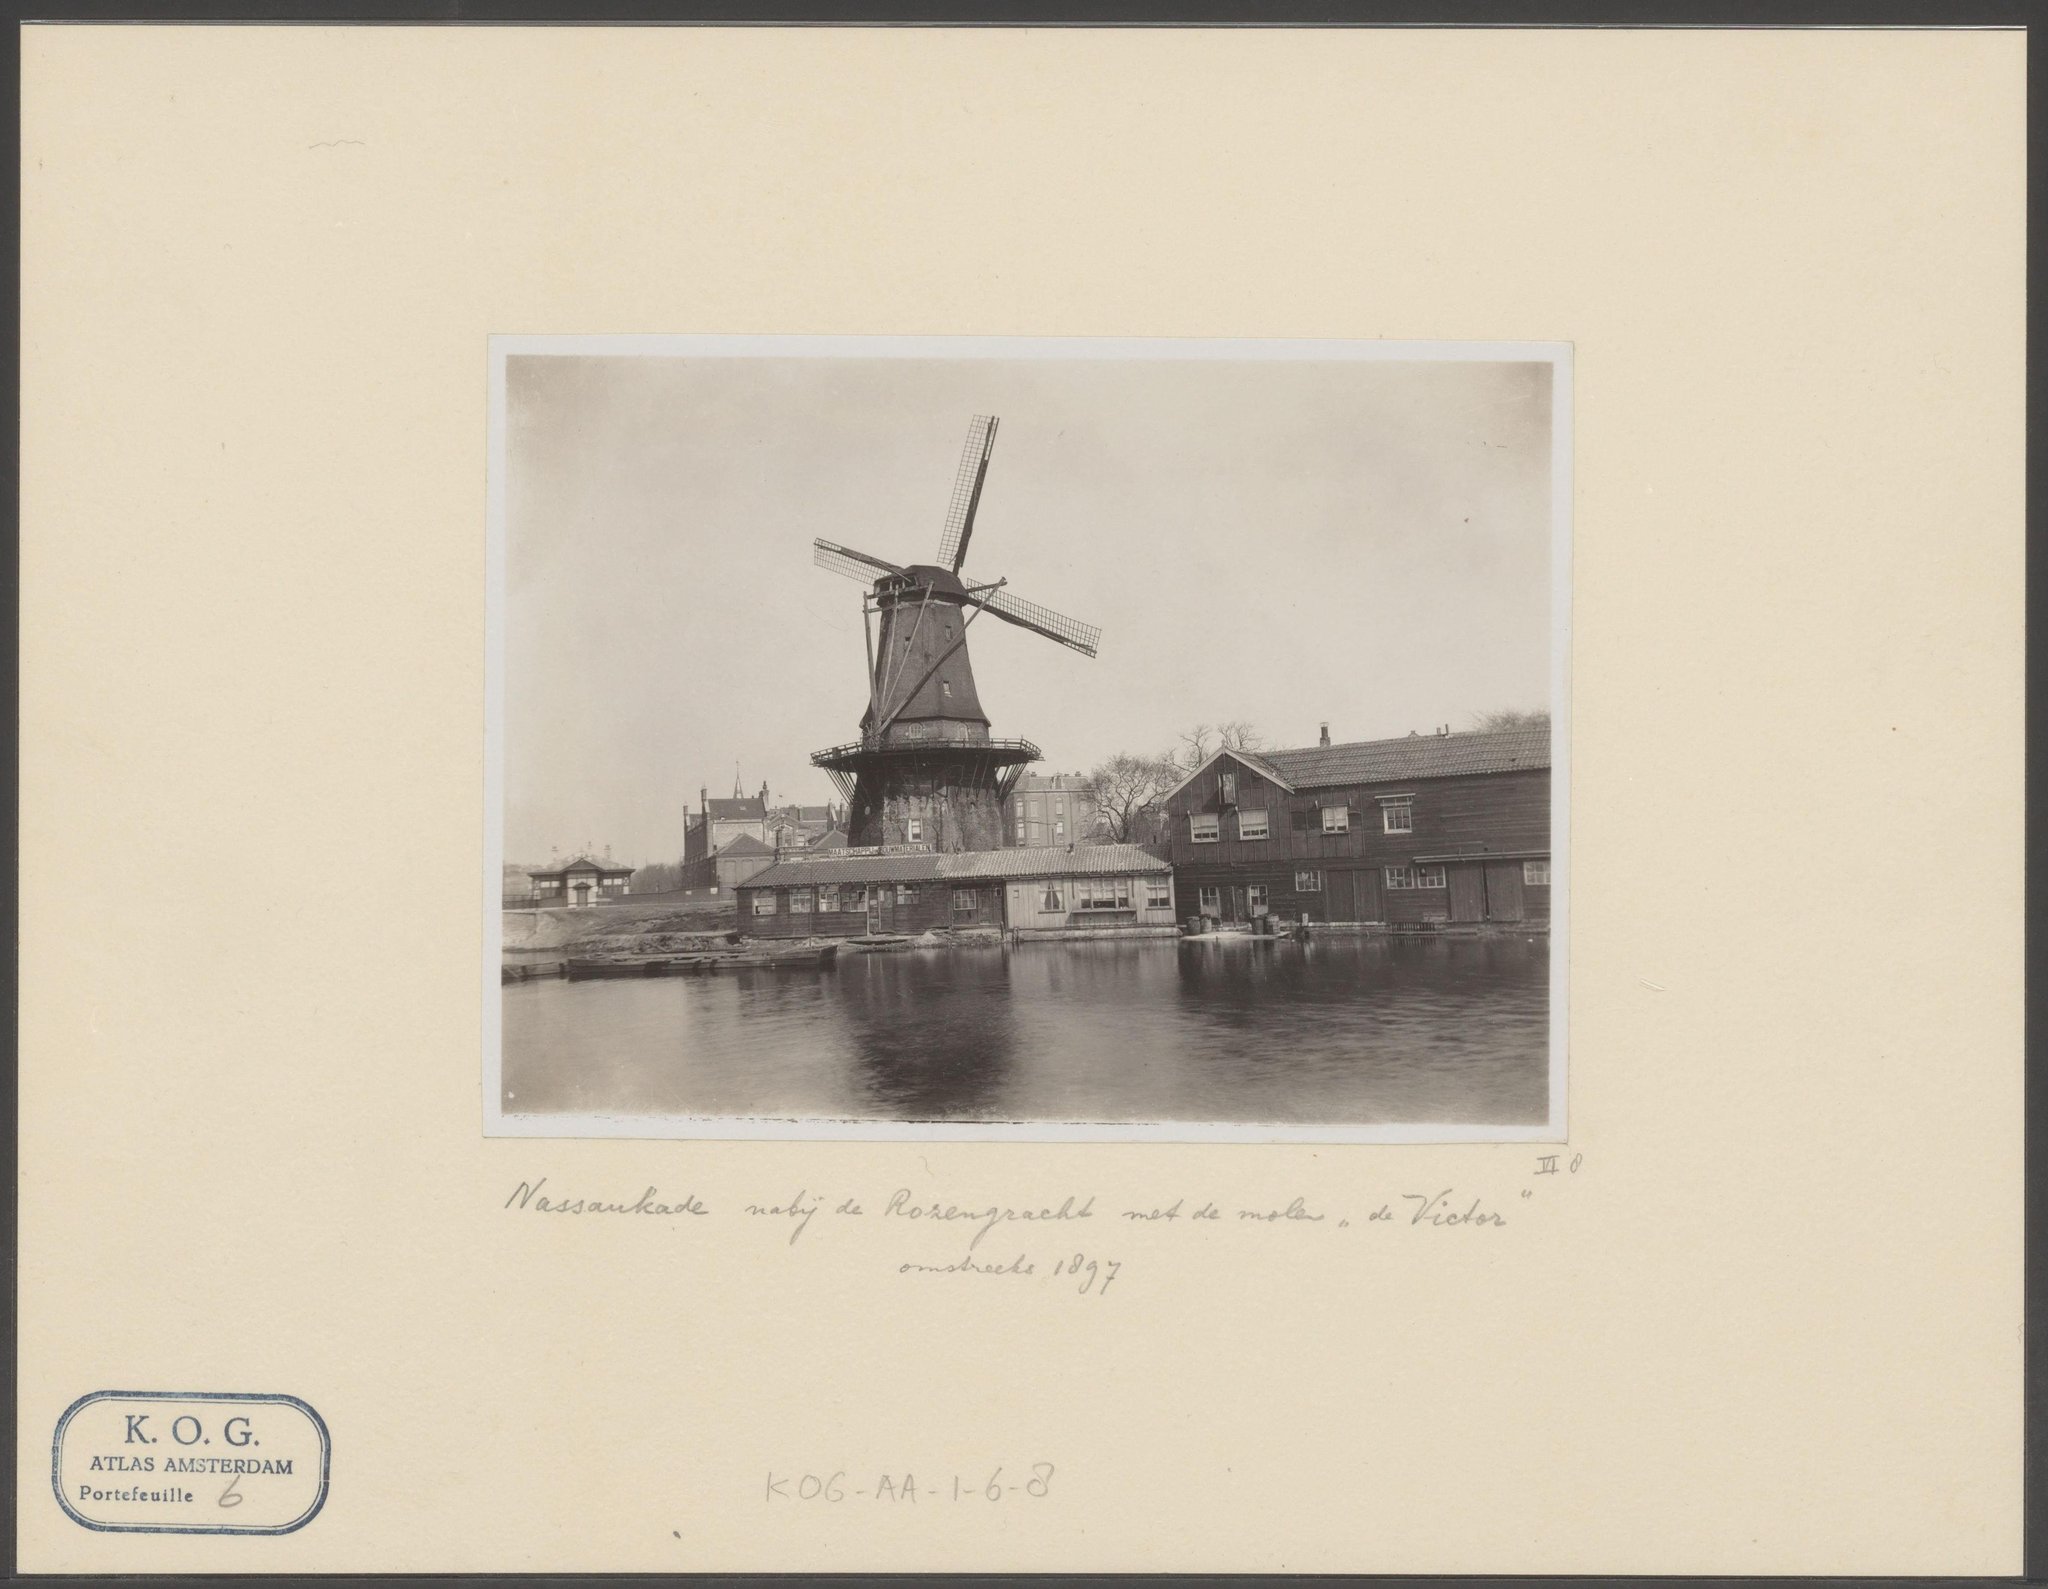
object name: photograph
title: Gezicht op molen De Victor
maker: Anonymous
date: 1897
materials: paper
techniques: gelatin silver print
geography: amsterdam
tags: city-view in general; 'veduta', canal, windmill in landscape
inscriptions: inscription: ‘Nassaukade nabij de Rozengracht met de molen "de Victor" / omstreeks 1897’, collector's mark: ‘6’ Lugt 1641b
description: Onderwerpsrubriek binnen de Atlas Amsterdam: Buitensingel of wel: Gezichten langs en op de Stadsvest van Haarlemmerpoort tot Raampoort.